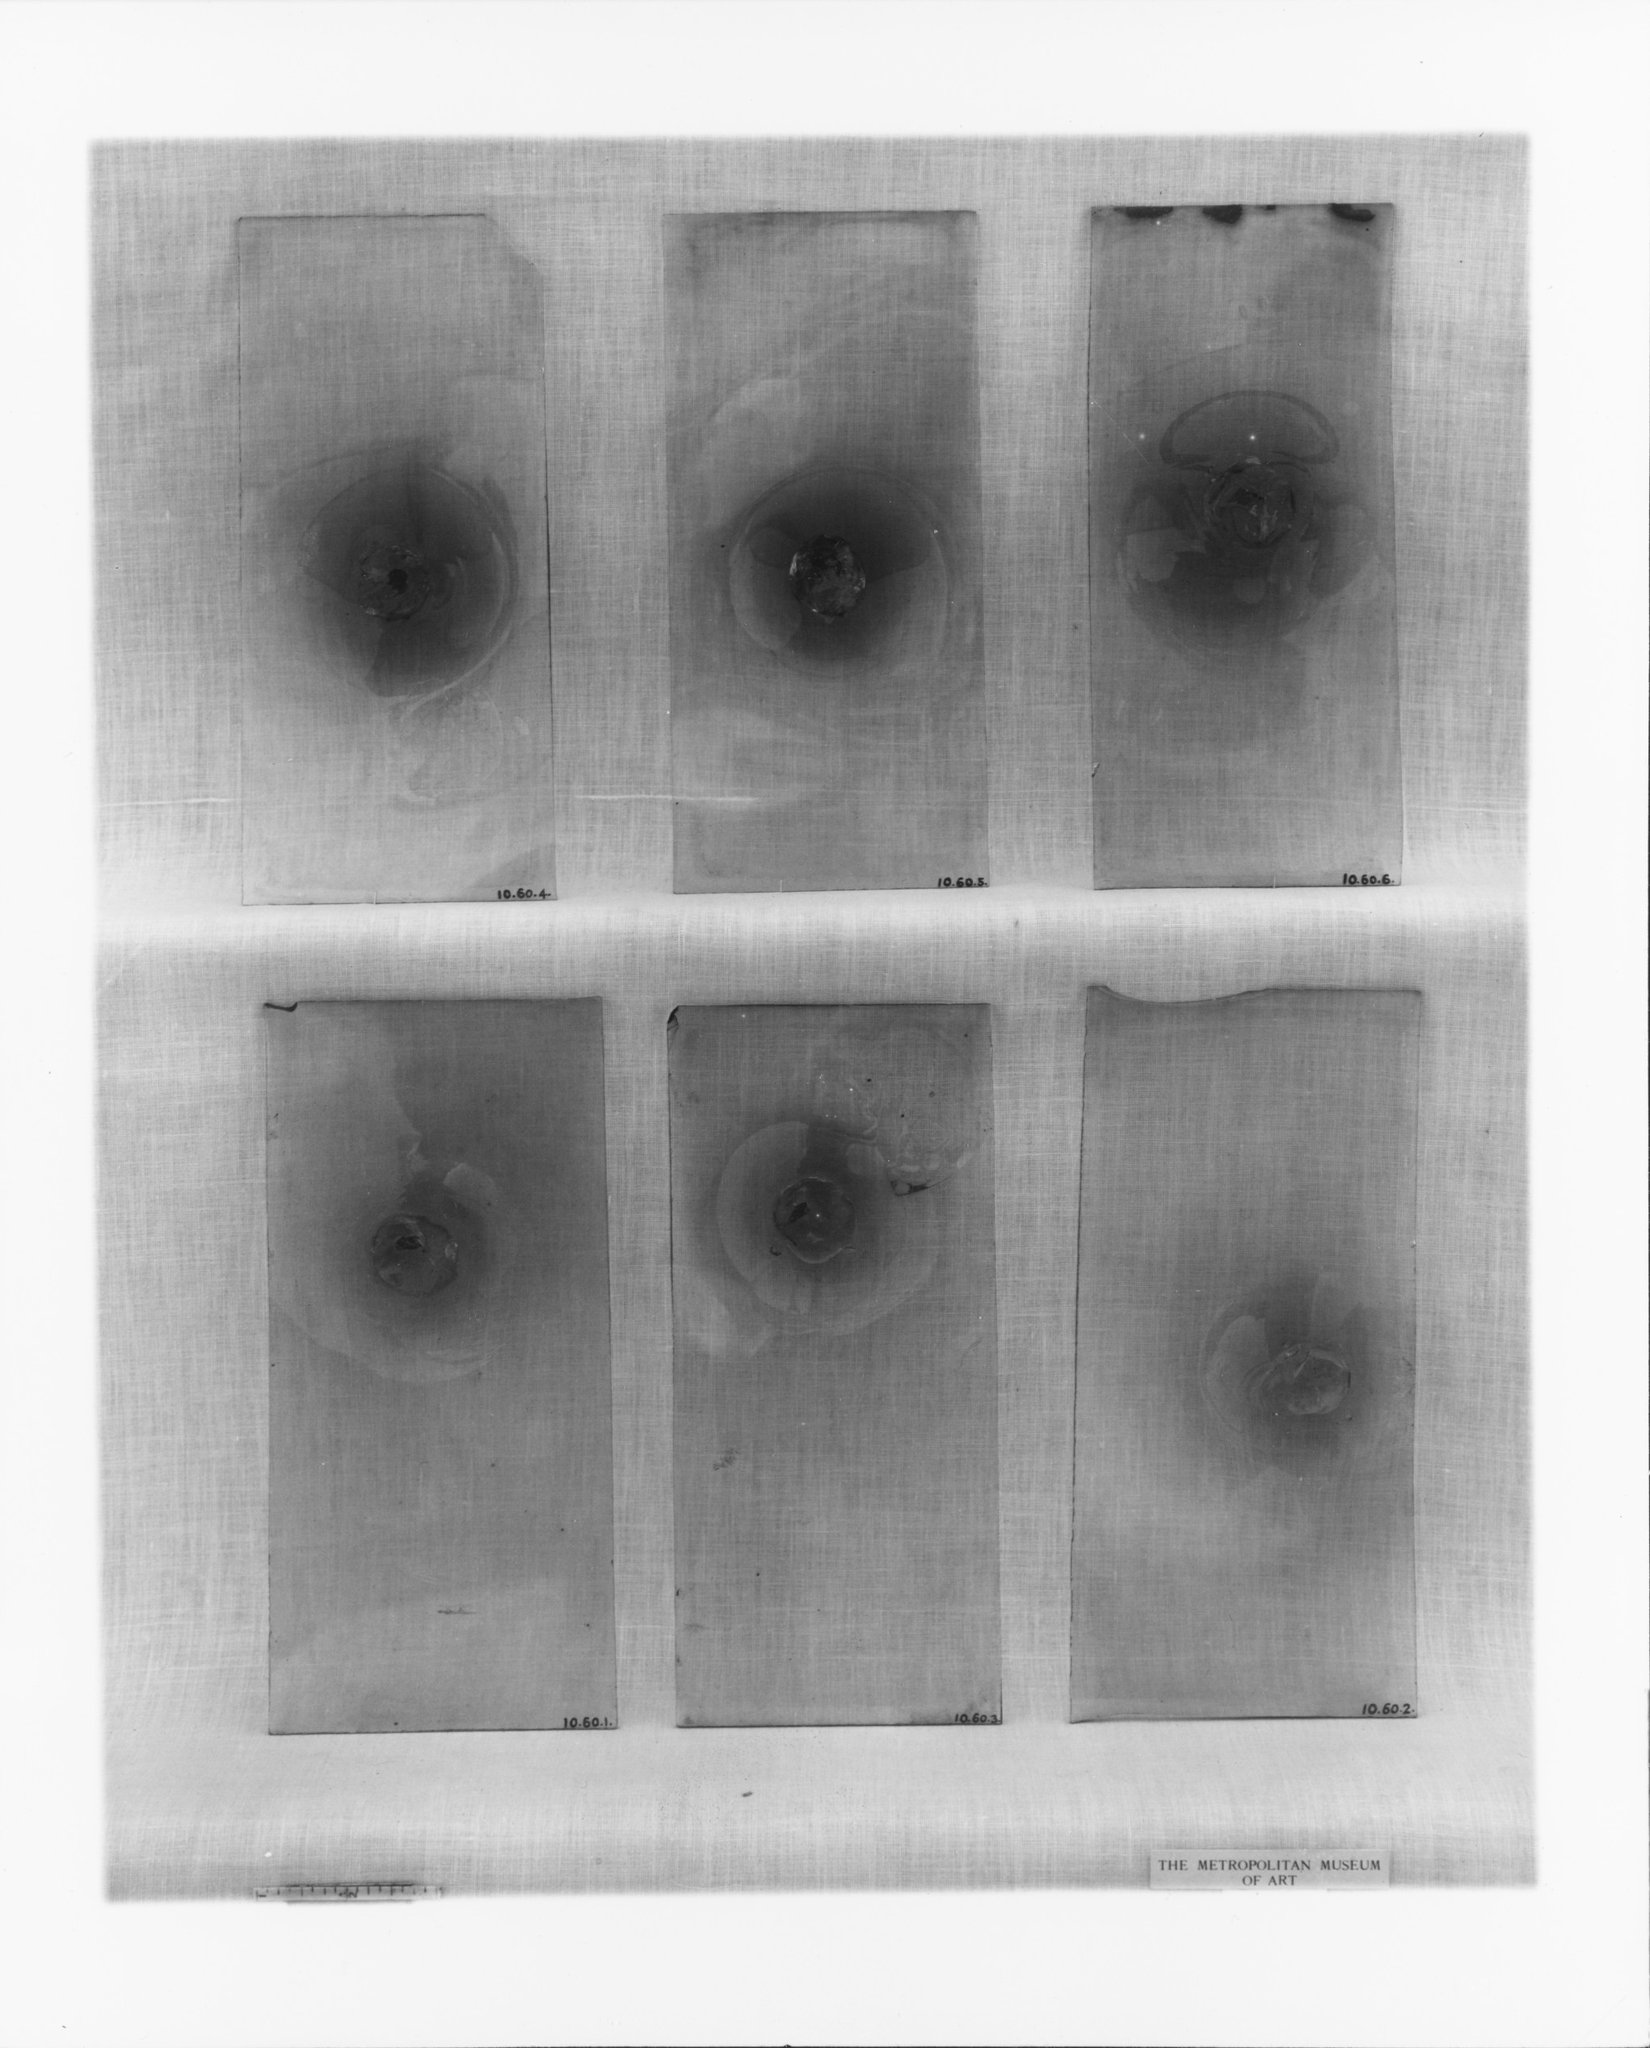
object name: windowpane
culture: american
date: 1701-1800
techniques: glassblowing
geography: united states